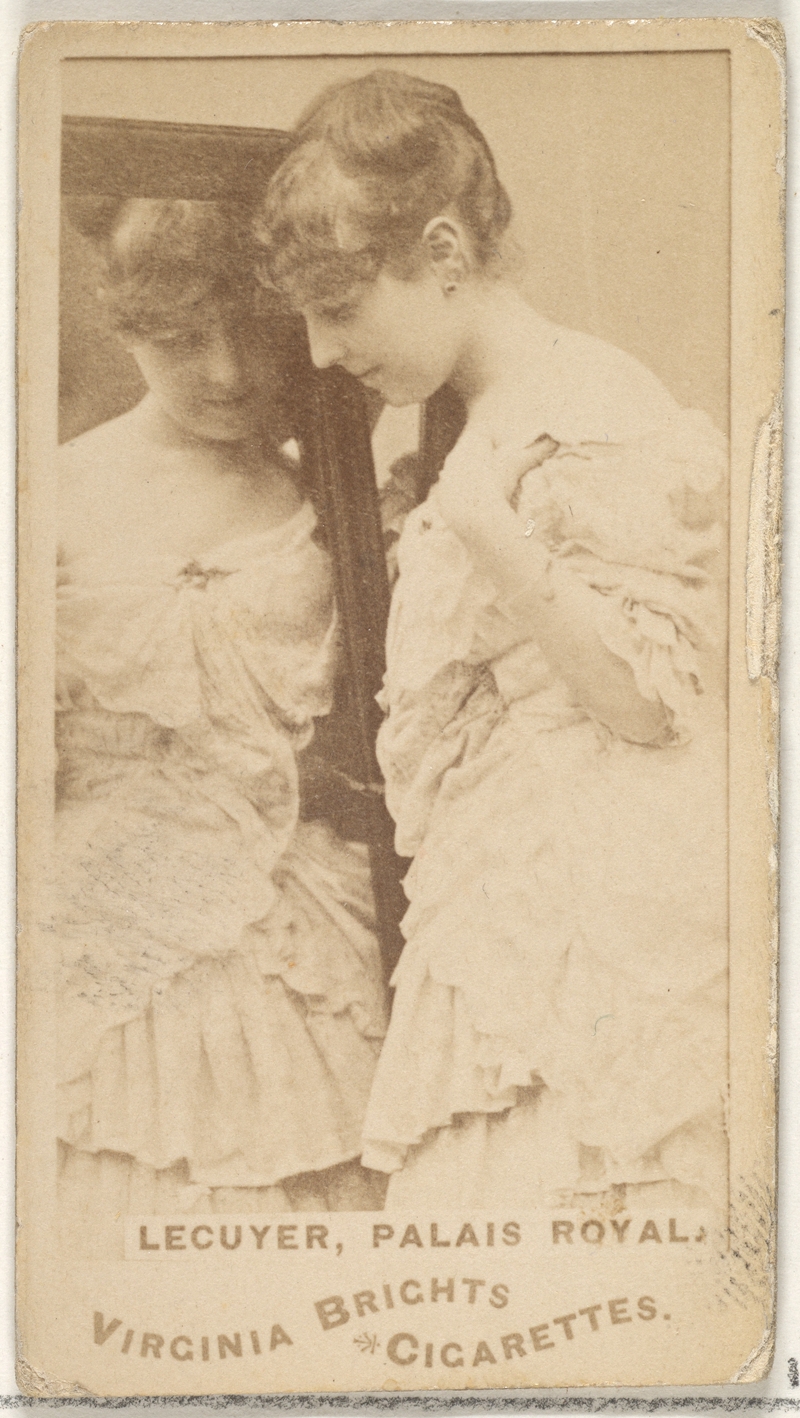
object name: photograph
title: Lecuyer, Palais Royal, from the Actors and Actresses series (N45, Type 1) for Virginia Brights Cigarettes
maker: allen & ginter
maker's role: publisher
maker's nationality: american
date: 1888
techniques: albumen silver print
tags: portraits,women,actresses,mirrors